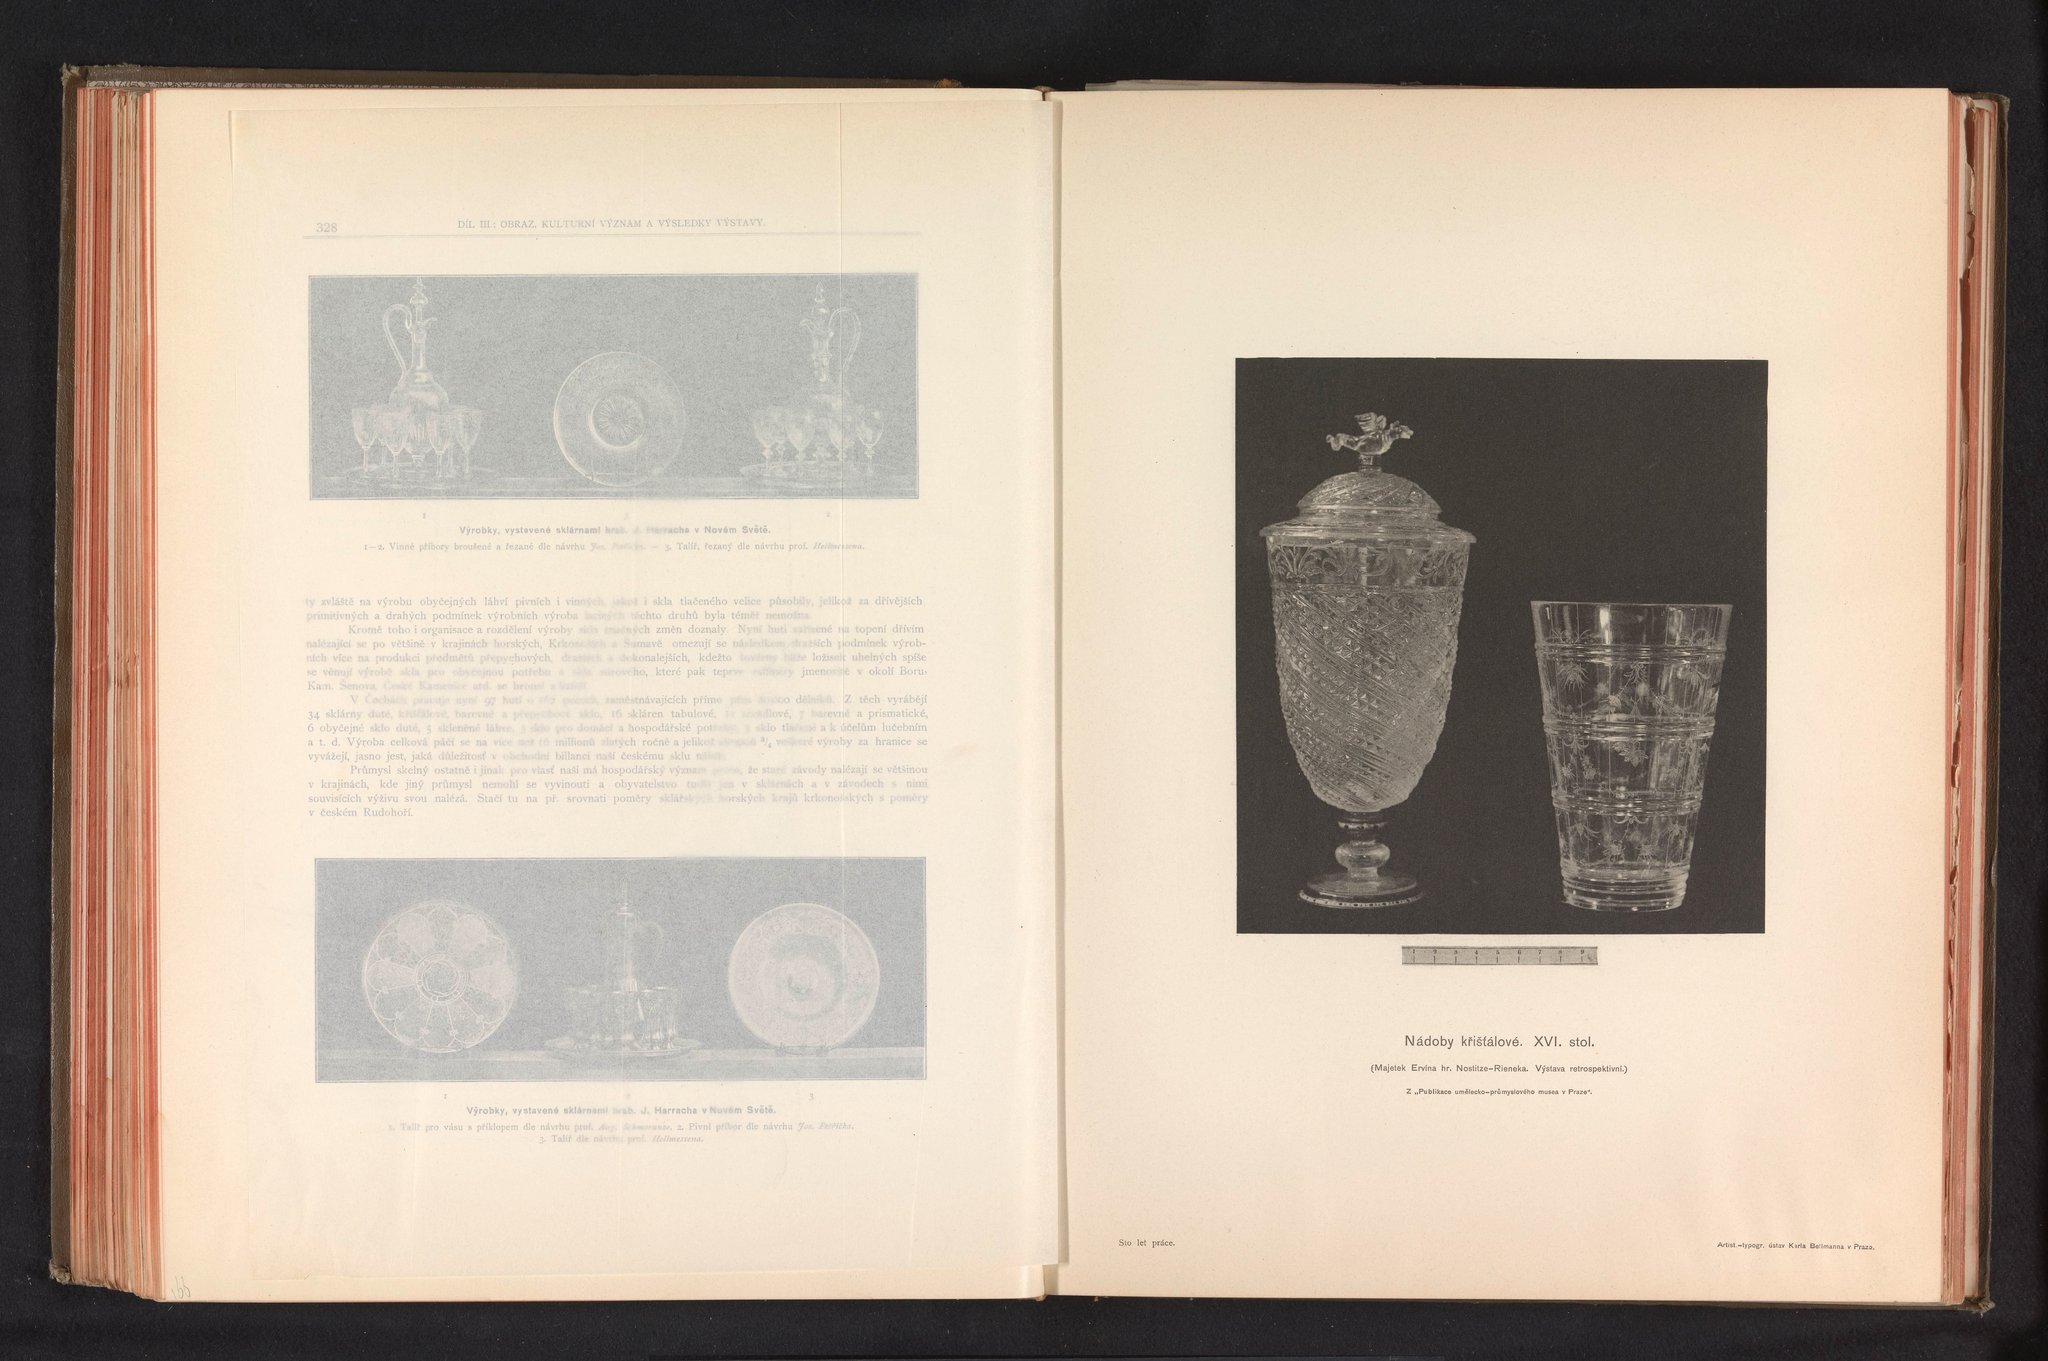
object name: photomechanical print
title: Nádoby kristalové. XVI. stol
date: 1890-1895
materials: paper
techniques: photograph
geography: prague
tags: pots, jars: chalice (calice), container of glass: bottle, jar, vase